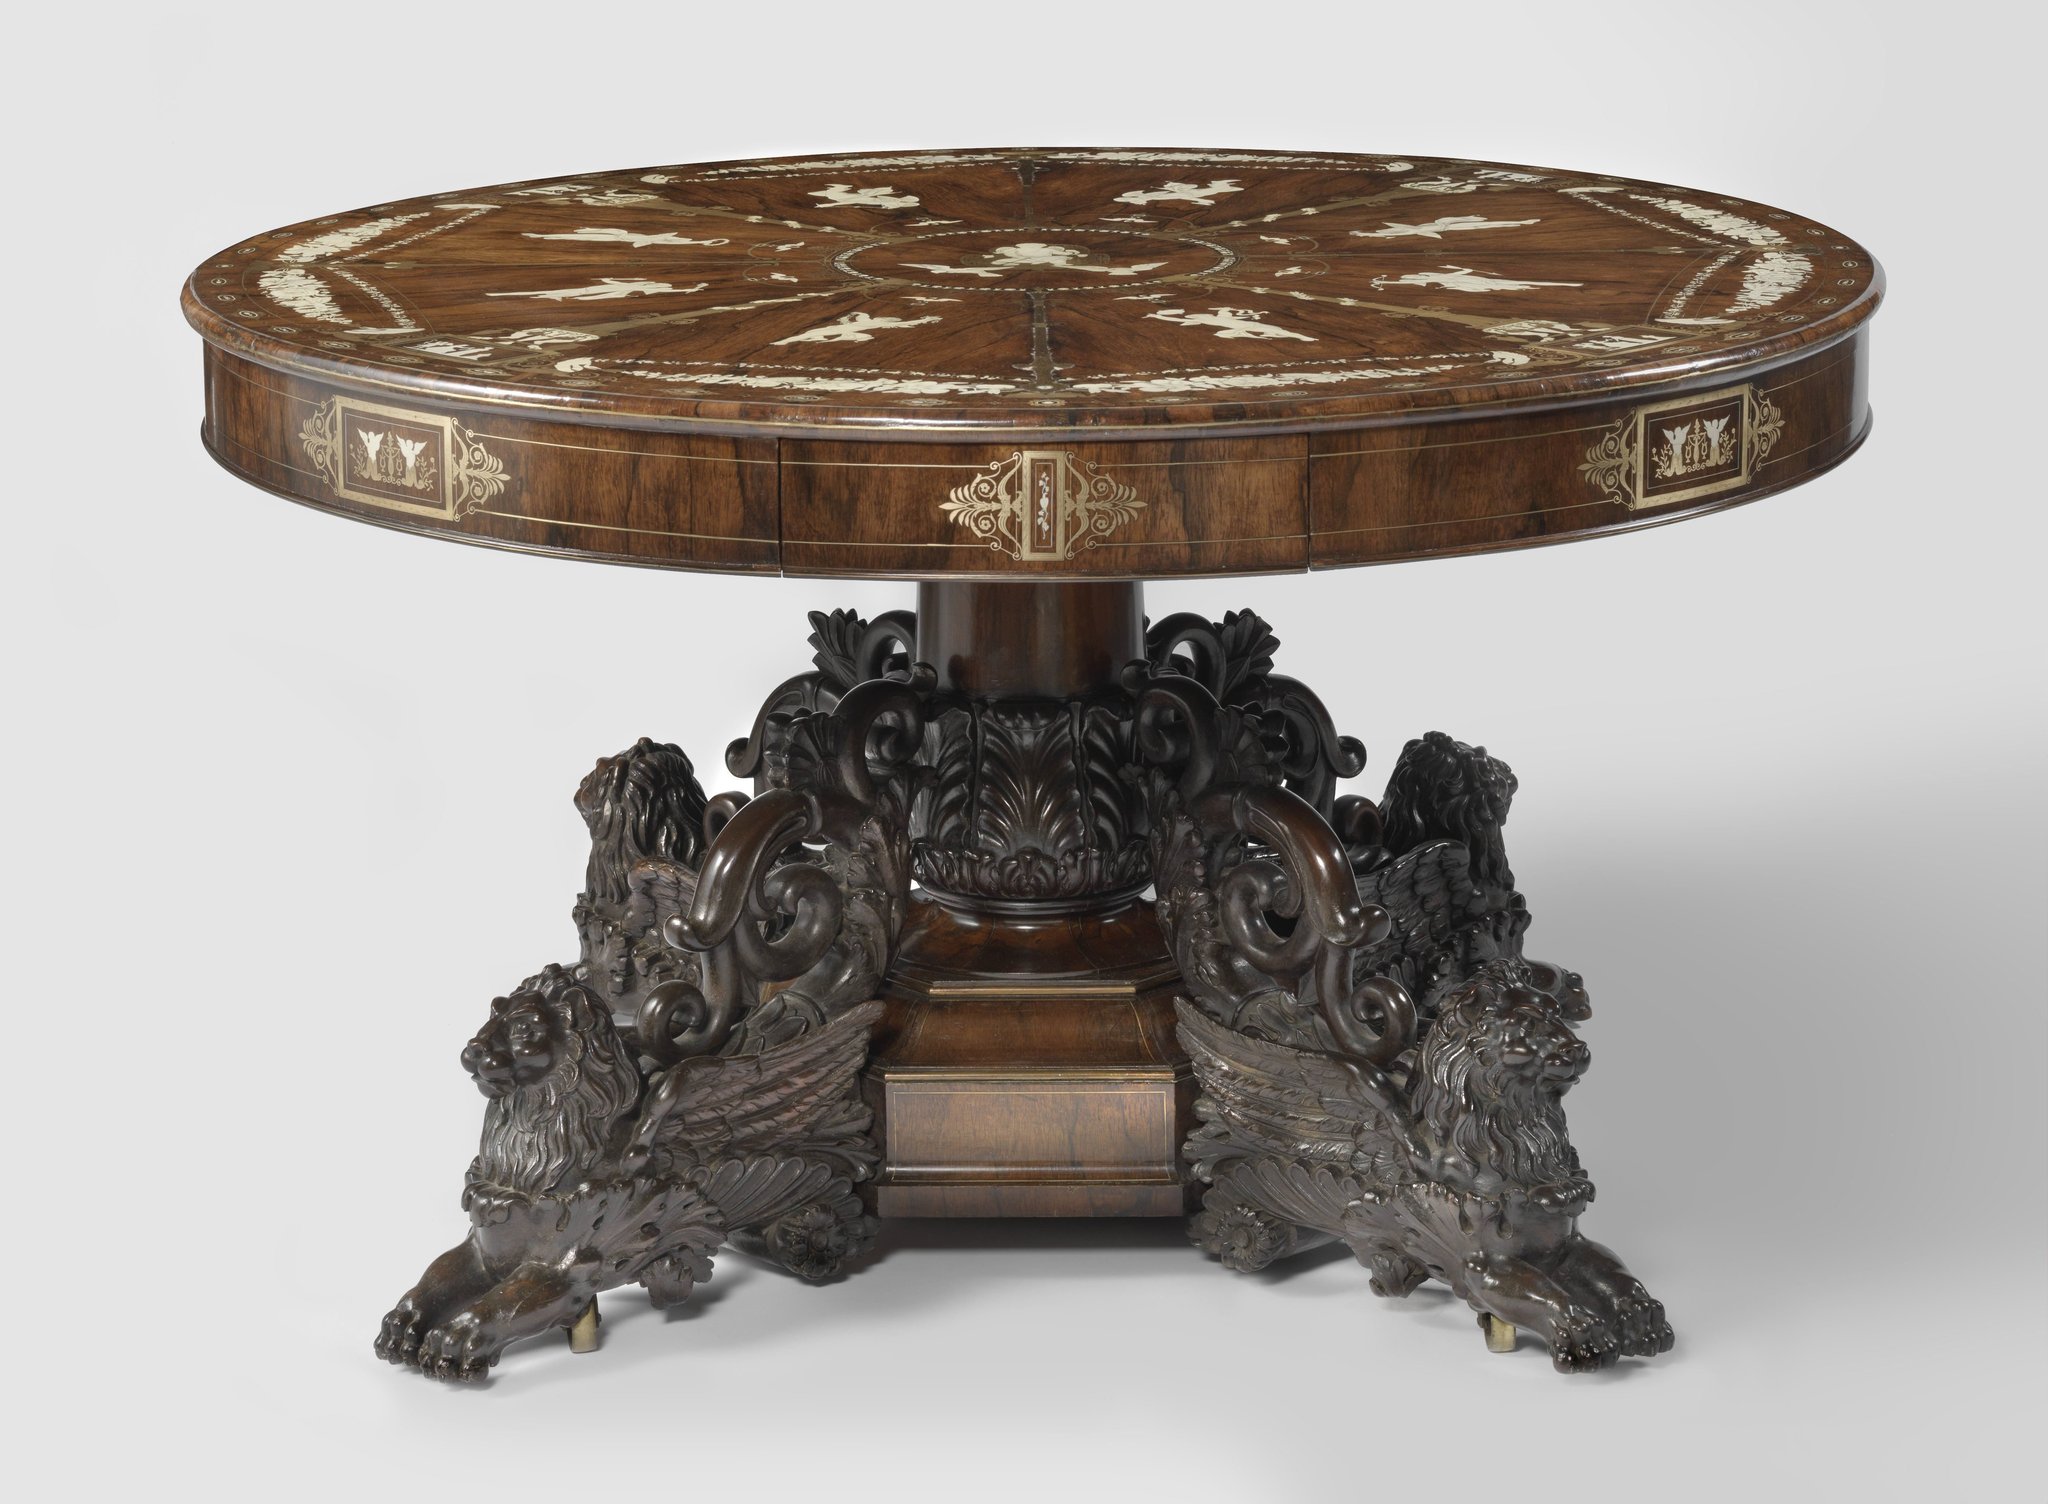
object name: table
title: Secretary, commode and table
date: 1834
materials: brass, copper, ivory, wood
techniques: marquetry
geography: paris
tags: ornament ~ hybrid animals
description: German-born Blechschmidt worked for leading Paris cabinetmakers and specialized in colourful marquetry (inlaid work) in various materials. He used an Italian Renaissance style for the marquetry here. Friedrich Frickhinger, one of his pupils and also a German active in Paris, made the furniture. He placed his signature and the date, 1834, on the inside of the secretary.